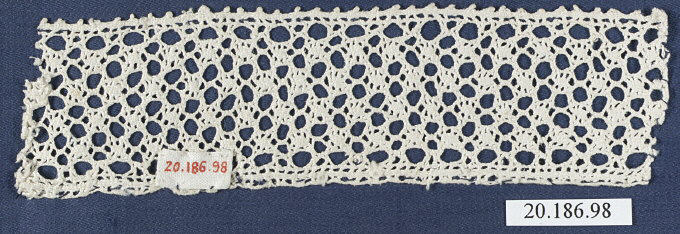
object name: strip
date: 1501-1700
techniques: lace